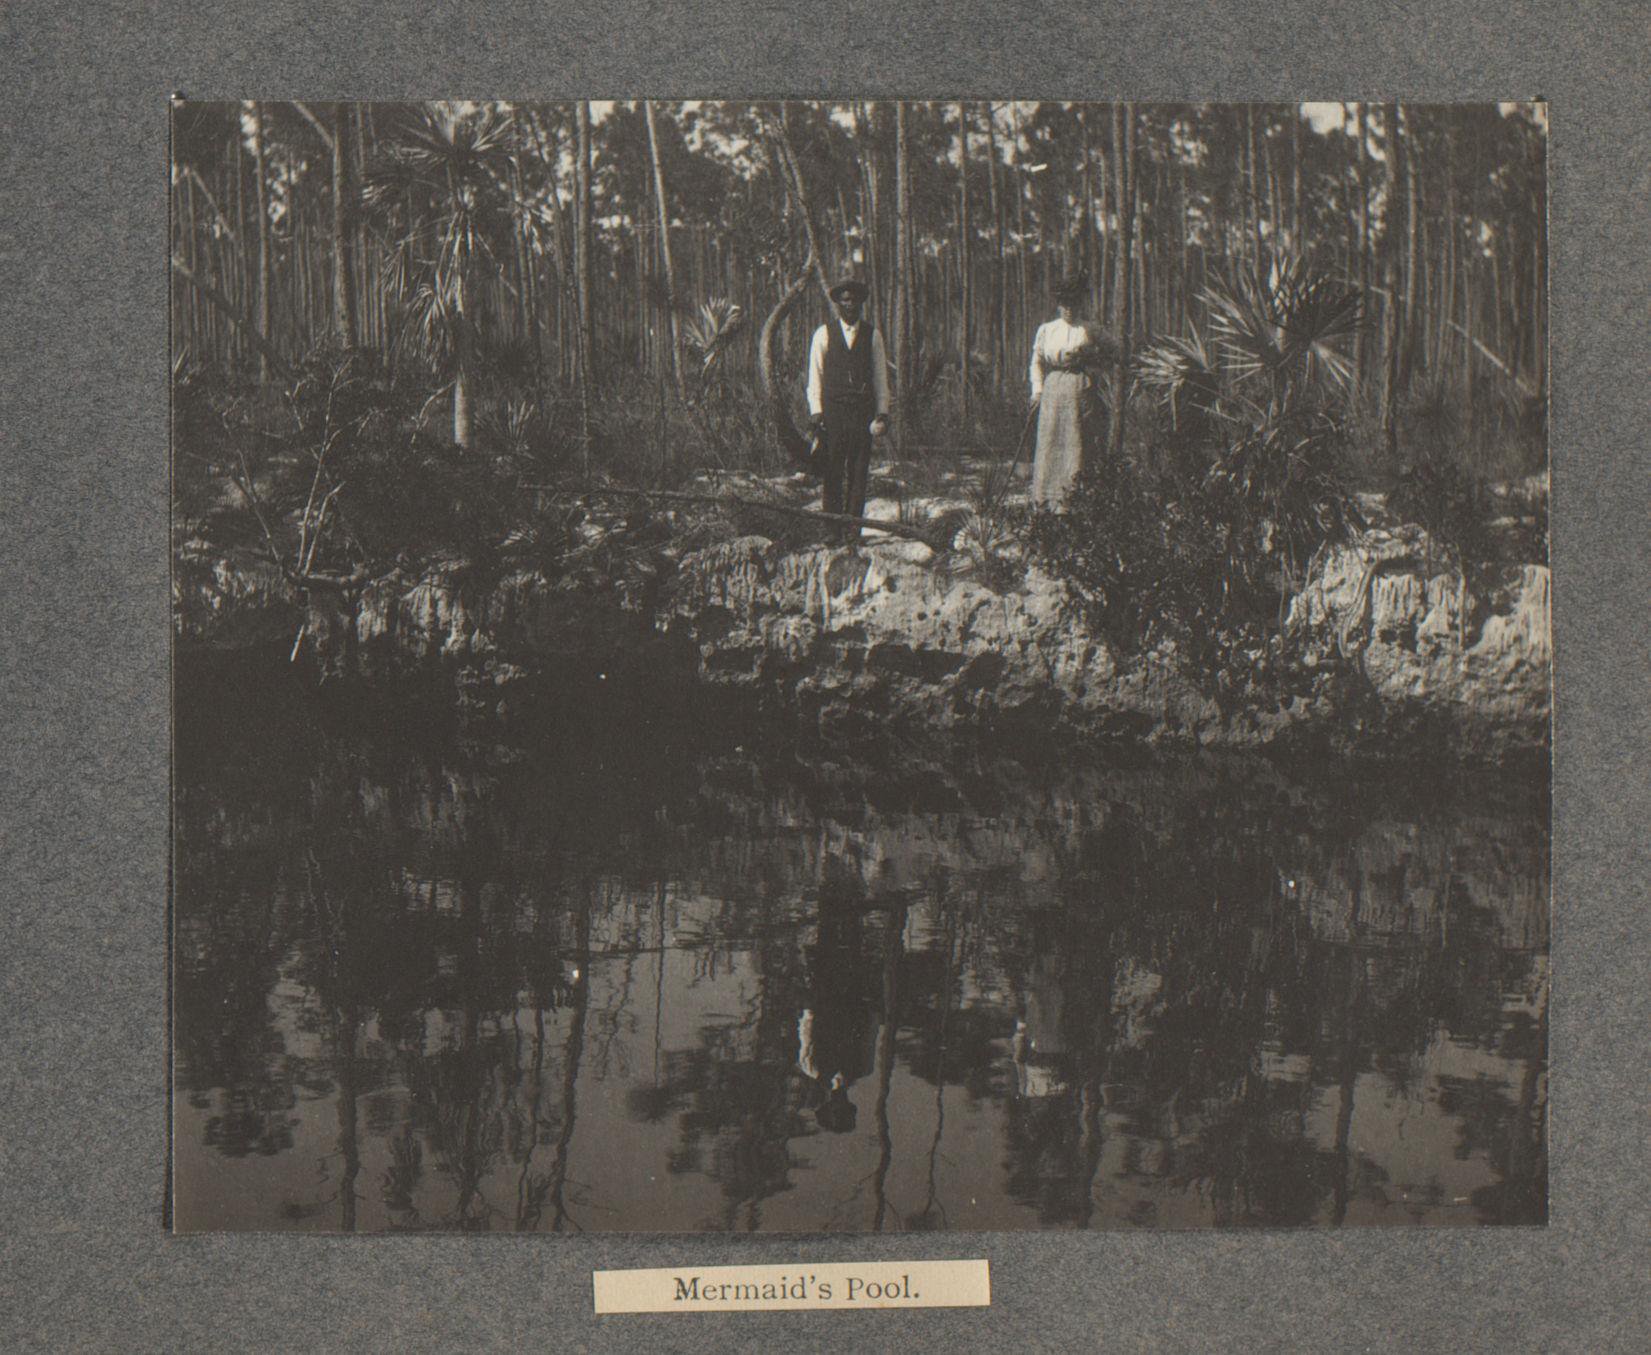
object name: photograph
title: Mermaid's Pool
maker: Anonymous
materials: paper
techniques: platinum process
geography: nassau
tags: pool, puddle (+ landscape with figures, staffage)